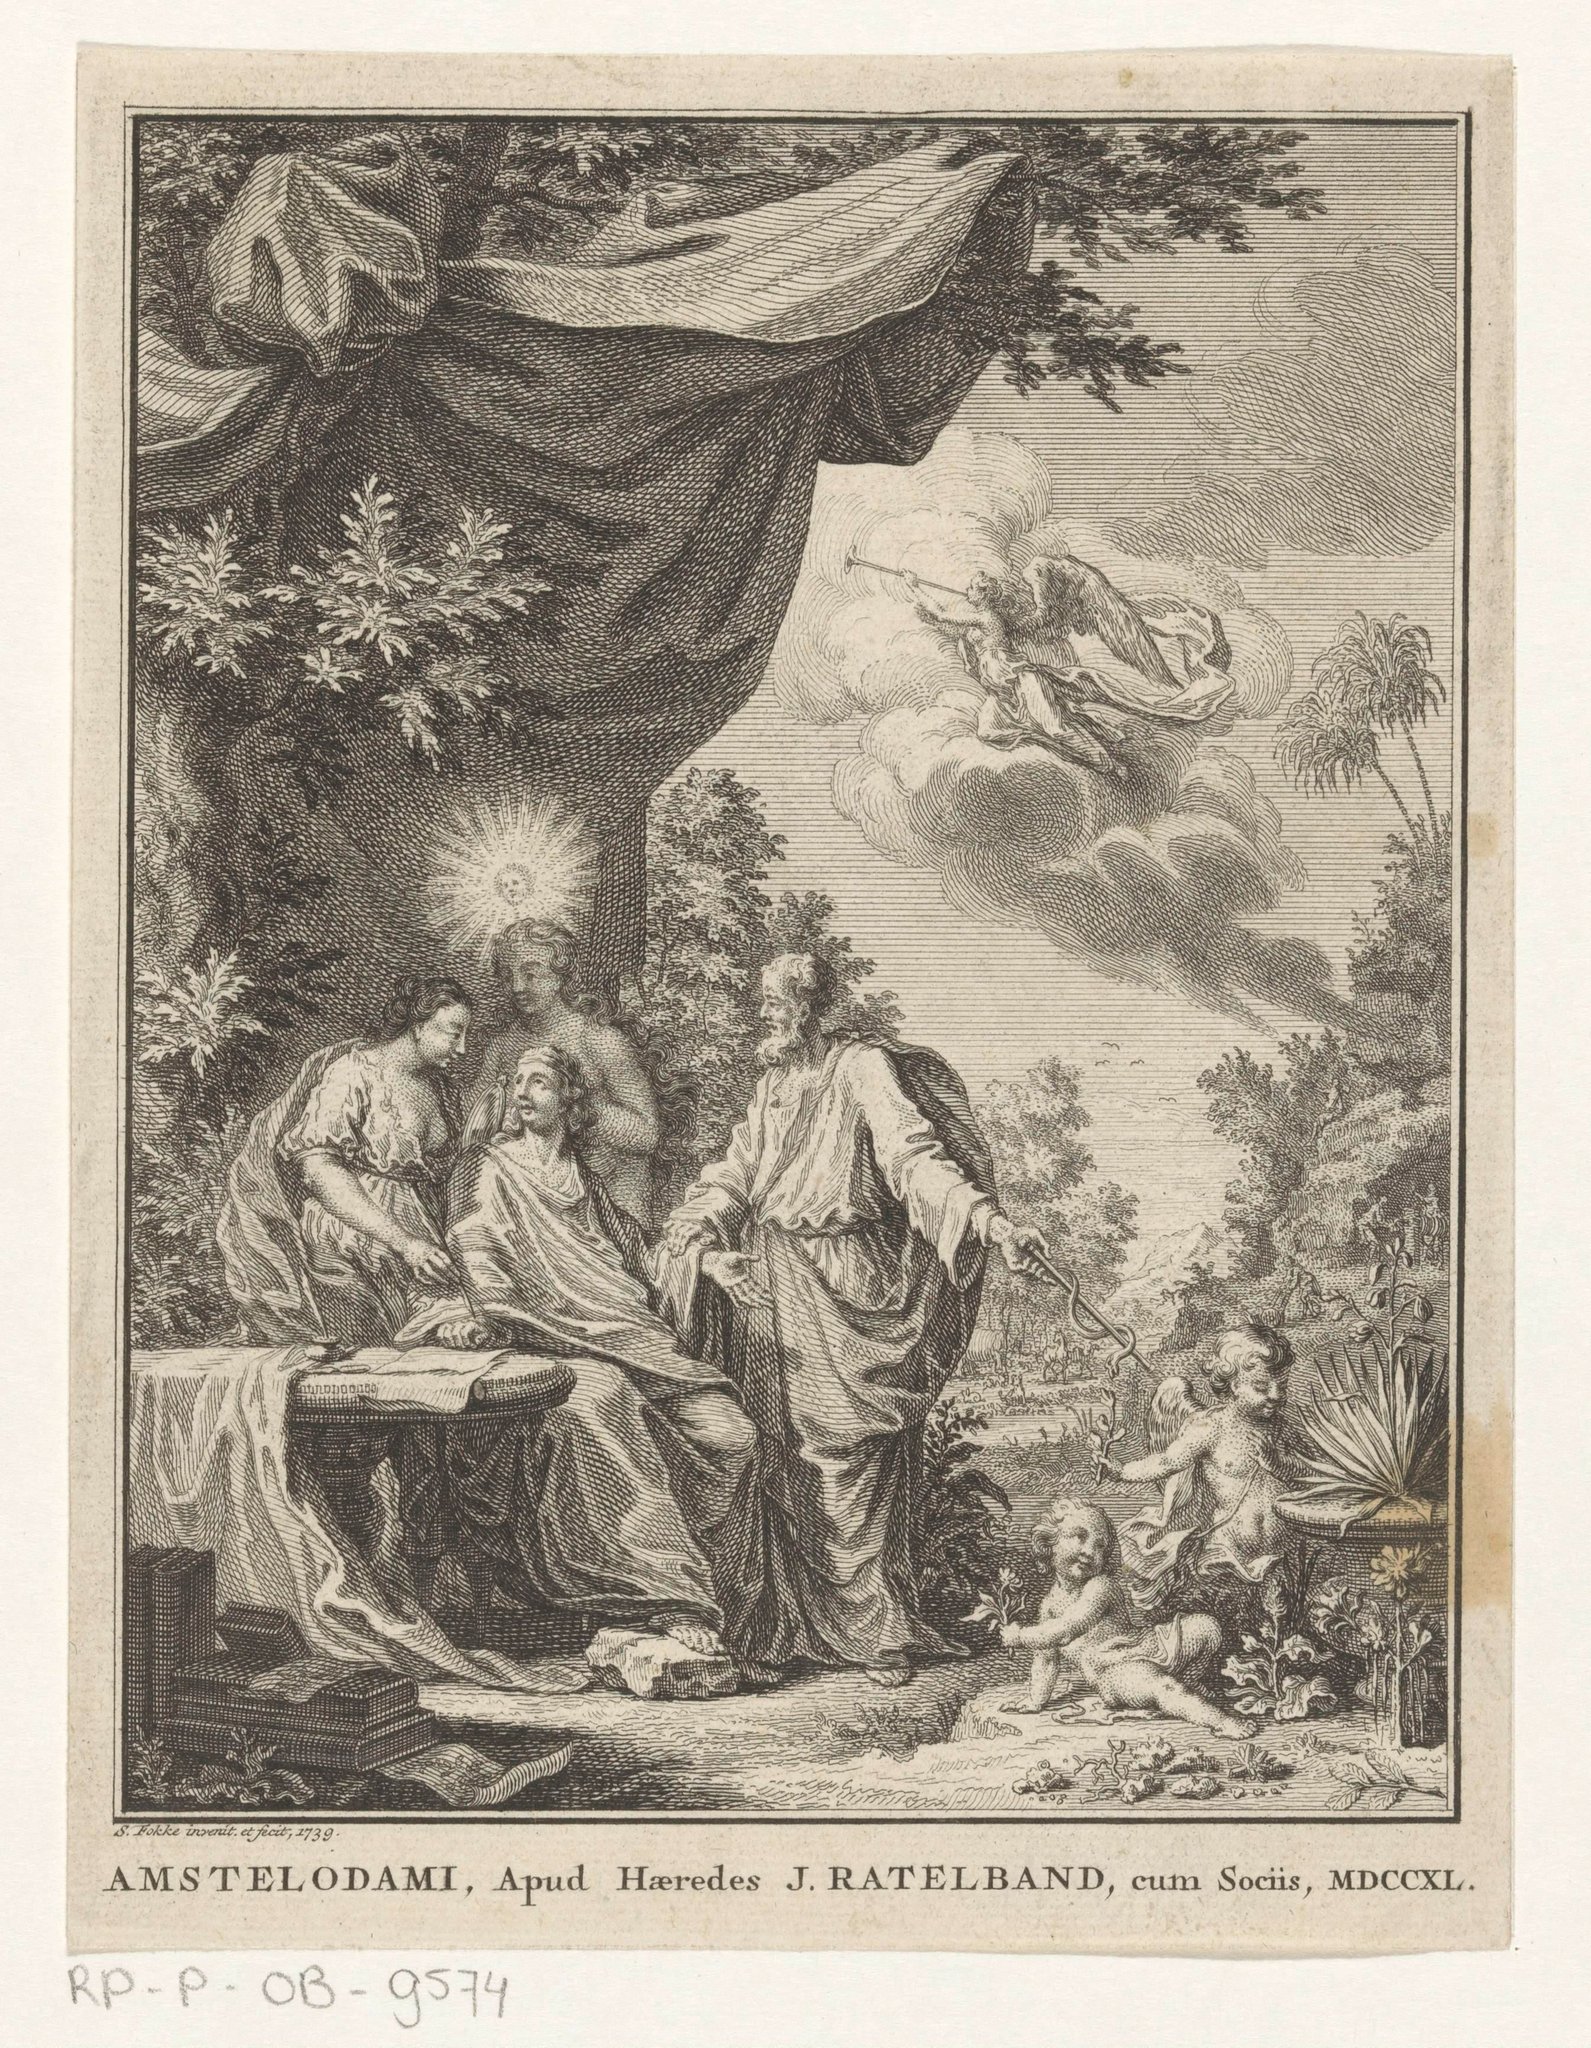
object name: print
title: Titelpagina voor: David de Gorter, Materies medica, exhibens virium medicamentorum simplicum, 1740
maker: simon fokke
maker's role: draughtsman, print maker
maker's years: 1712-1784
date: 1739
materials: paper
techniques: engraving, etching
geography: amsterdam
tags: fides (faith) as roman personification, (story of) aesculapius (asclepius), prudentia (prudence) as roman personification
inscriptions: collector's mark: Lugt 2228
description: Voorzichtigheid met spiegel, Geloof met brandende zon op het hoofd en Asclepius met esculaap staan rondom een zittende figuur. Voorzichtigheid overhandigt hem een schrijfveer. Rechts twee putti bij bloemen. In de achtergrond werken mensen op het land en Fama blazend op een bazuin.